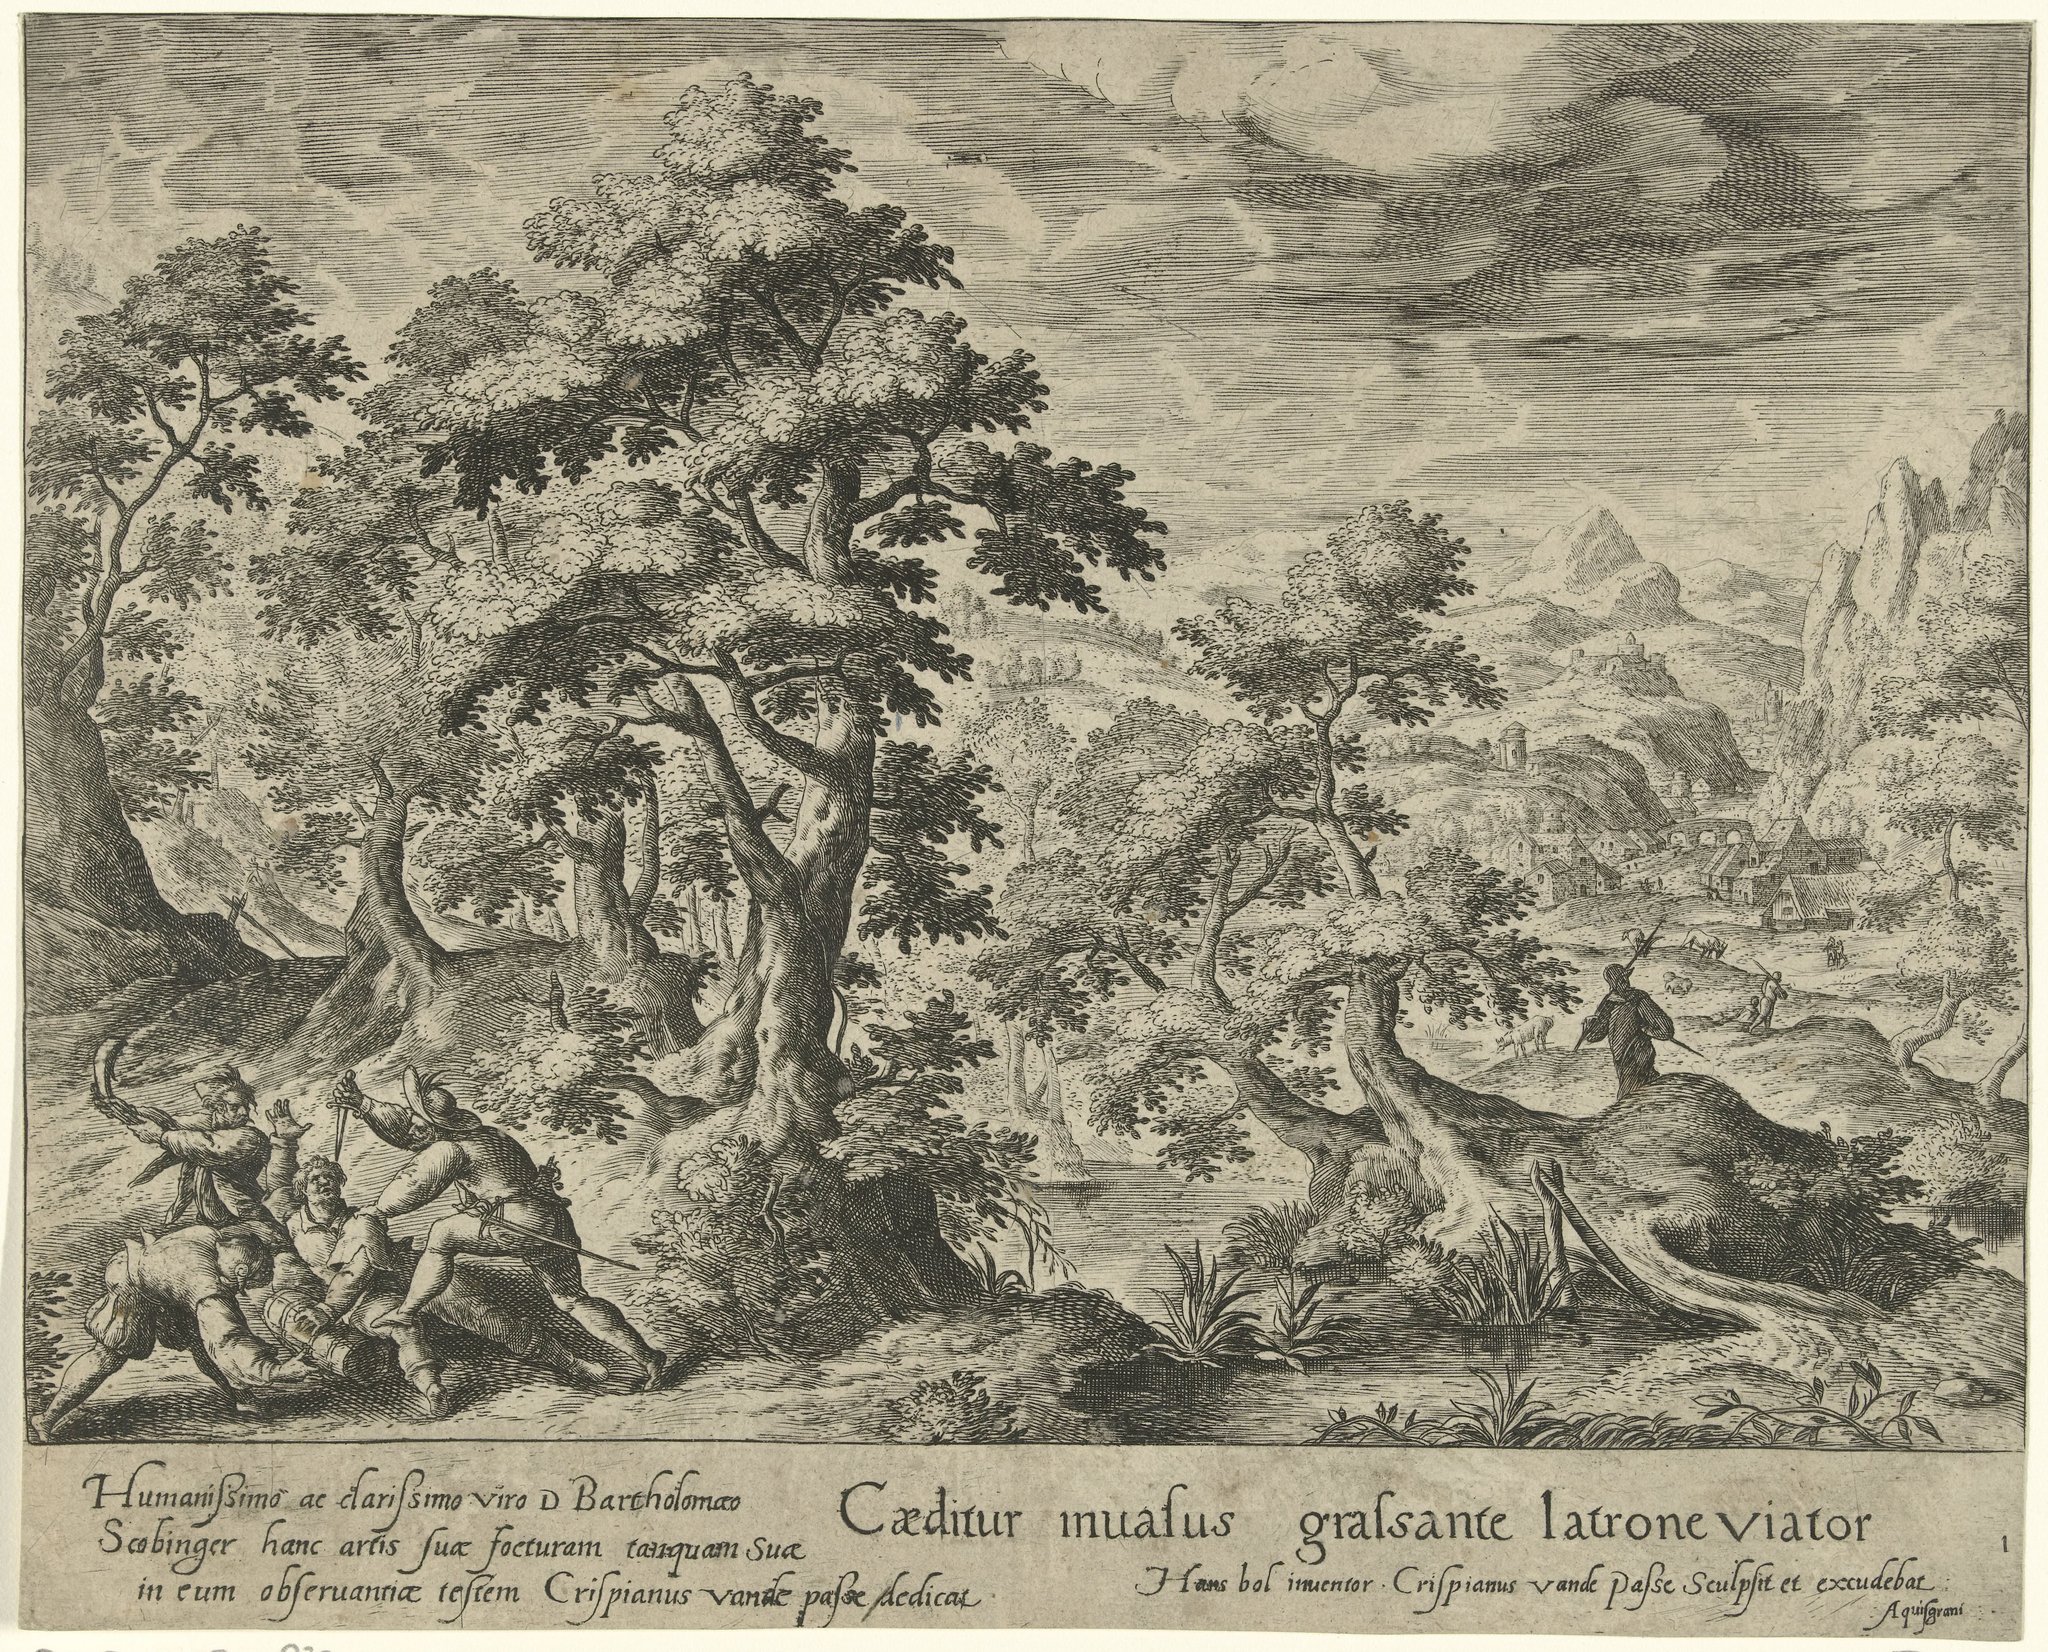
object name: titelprent, frontispice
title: Landschappen met scènes uit de gelijkenis van de barmhartige Samaritaan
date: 1588-1589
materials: paper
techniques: engraving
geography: aachen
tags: the traveller is attacked by robbers ~ parable of the good samaritan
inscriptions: collector's mark: Lugt 1337, collector's mark: Lugt 2228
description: In een bos wordt een reiziger door drie struikrovers aangevallen en neergestoken. In de marge een regel en een drieregelig onderschrift met een opdracht in het Latijn.